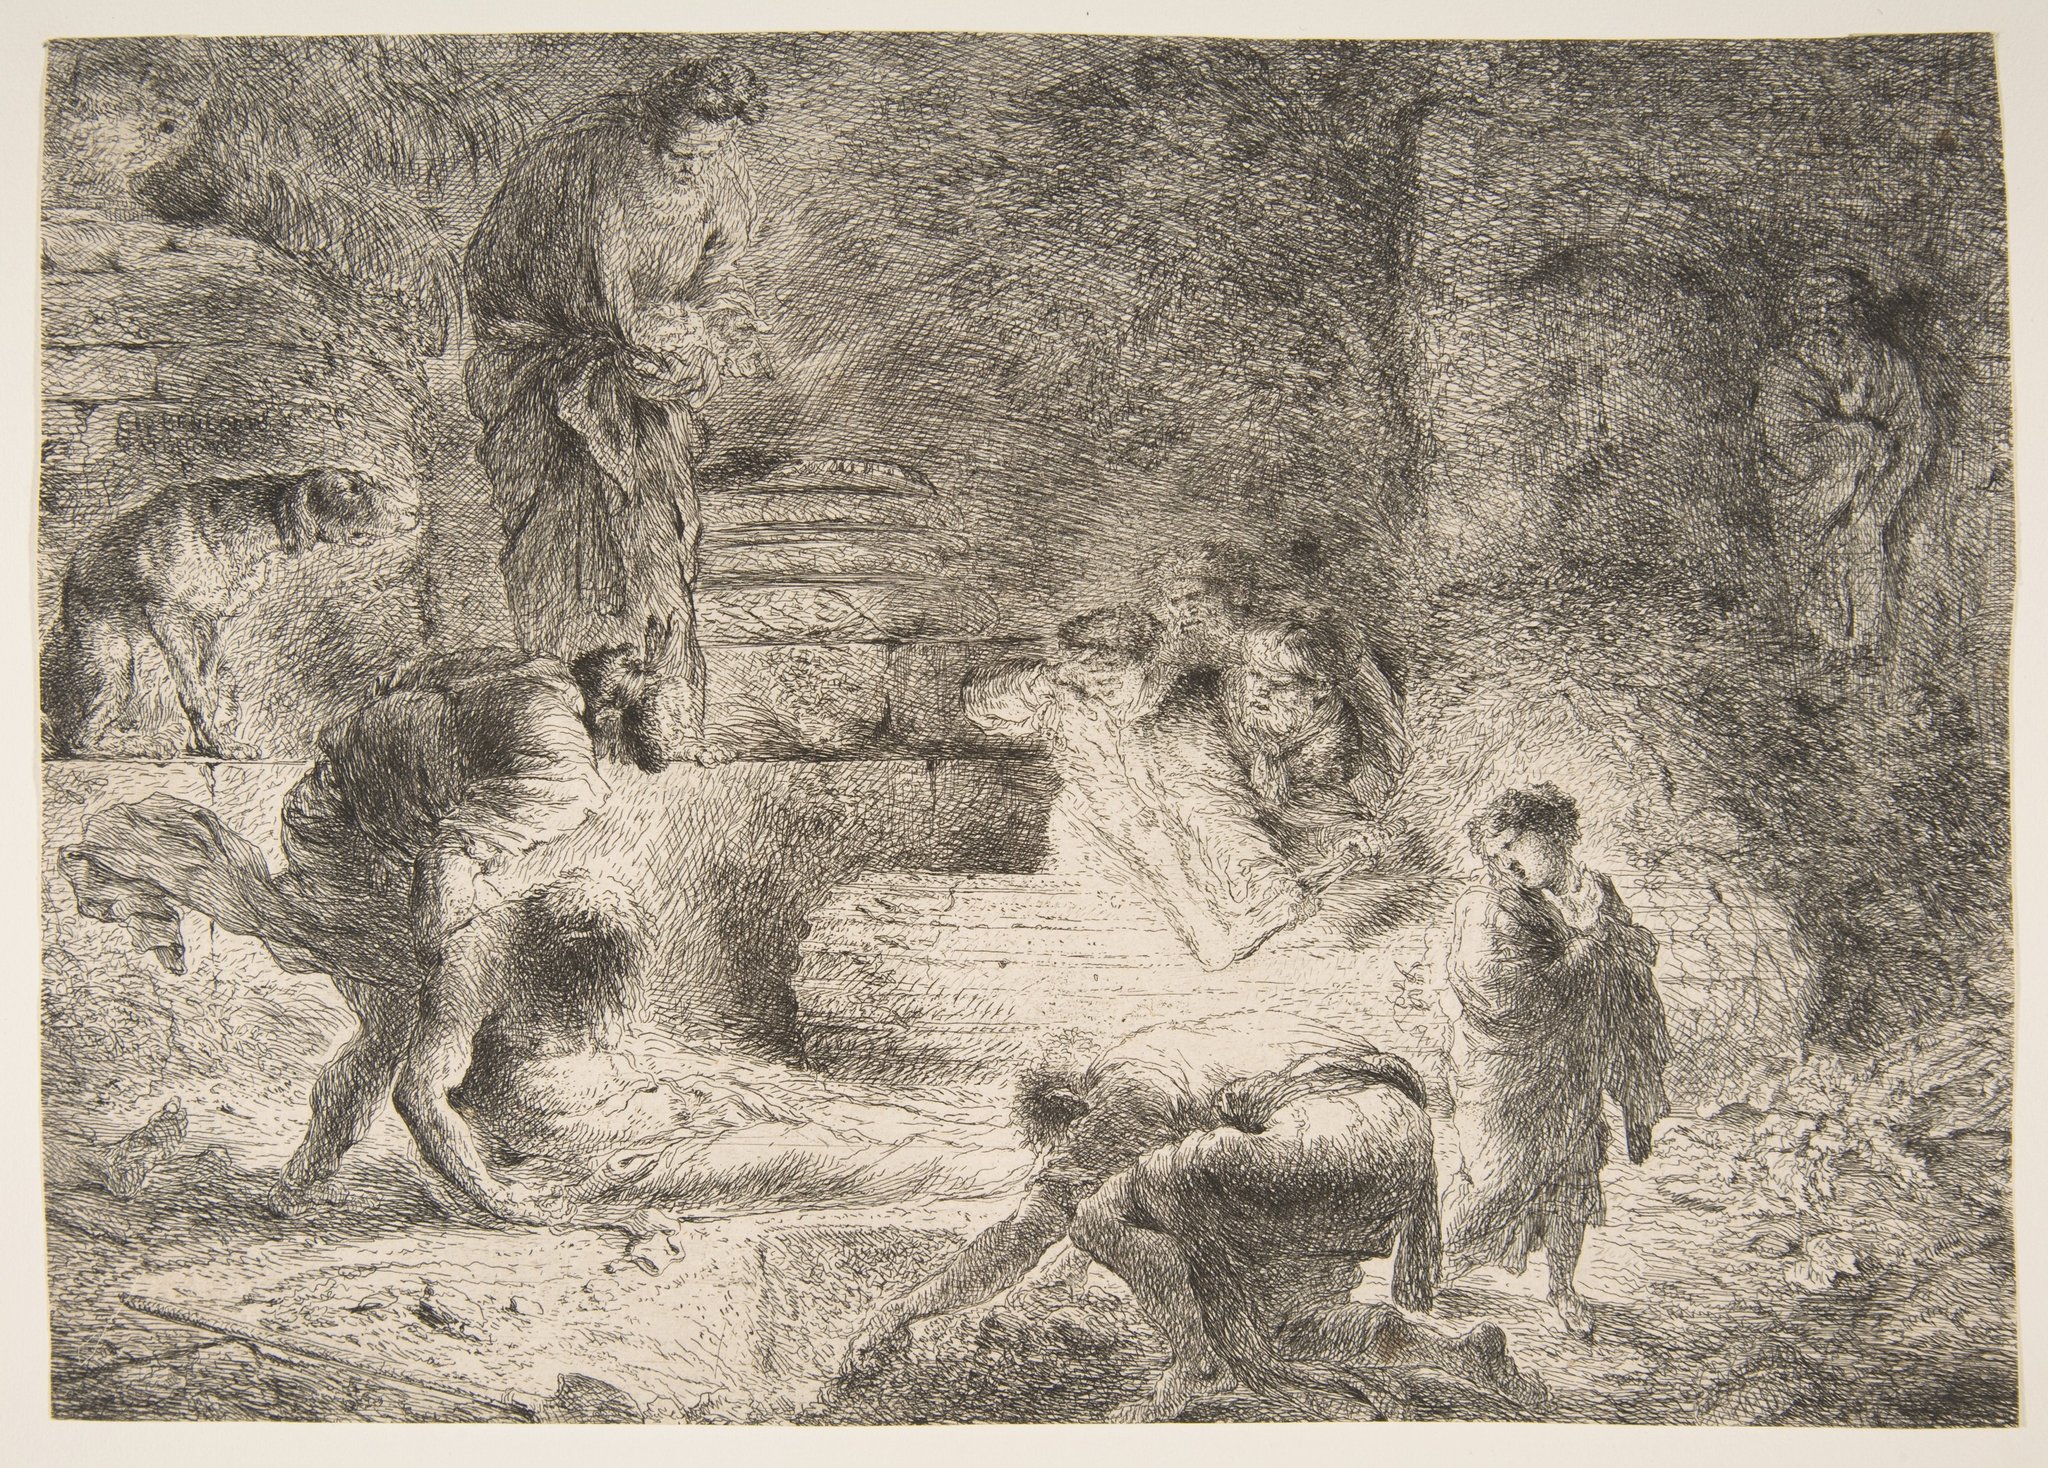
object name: print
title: Tobit burying the Dead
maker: giovanni benedetto castiglione (il grechetto)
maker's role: artist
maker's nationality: italian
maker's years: 1609-1664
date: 1647-1651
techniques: etching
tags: men,women,death